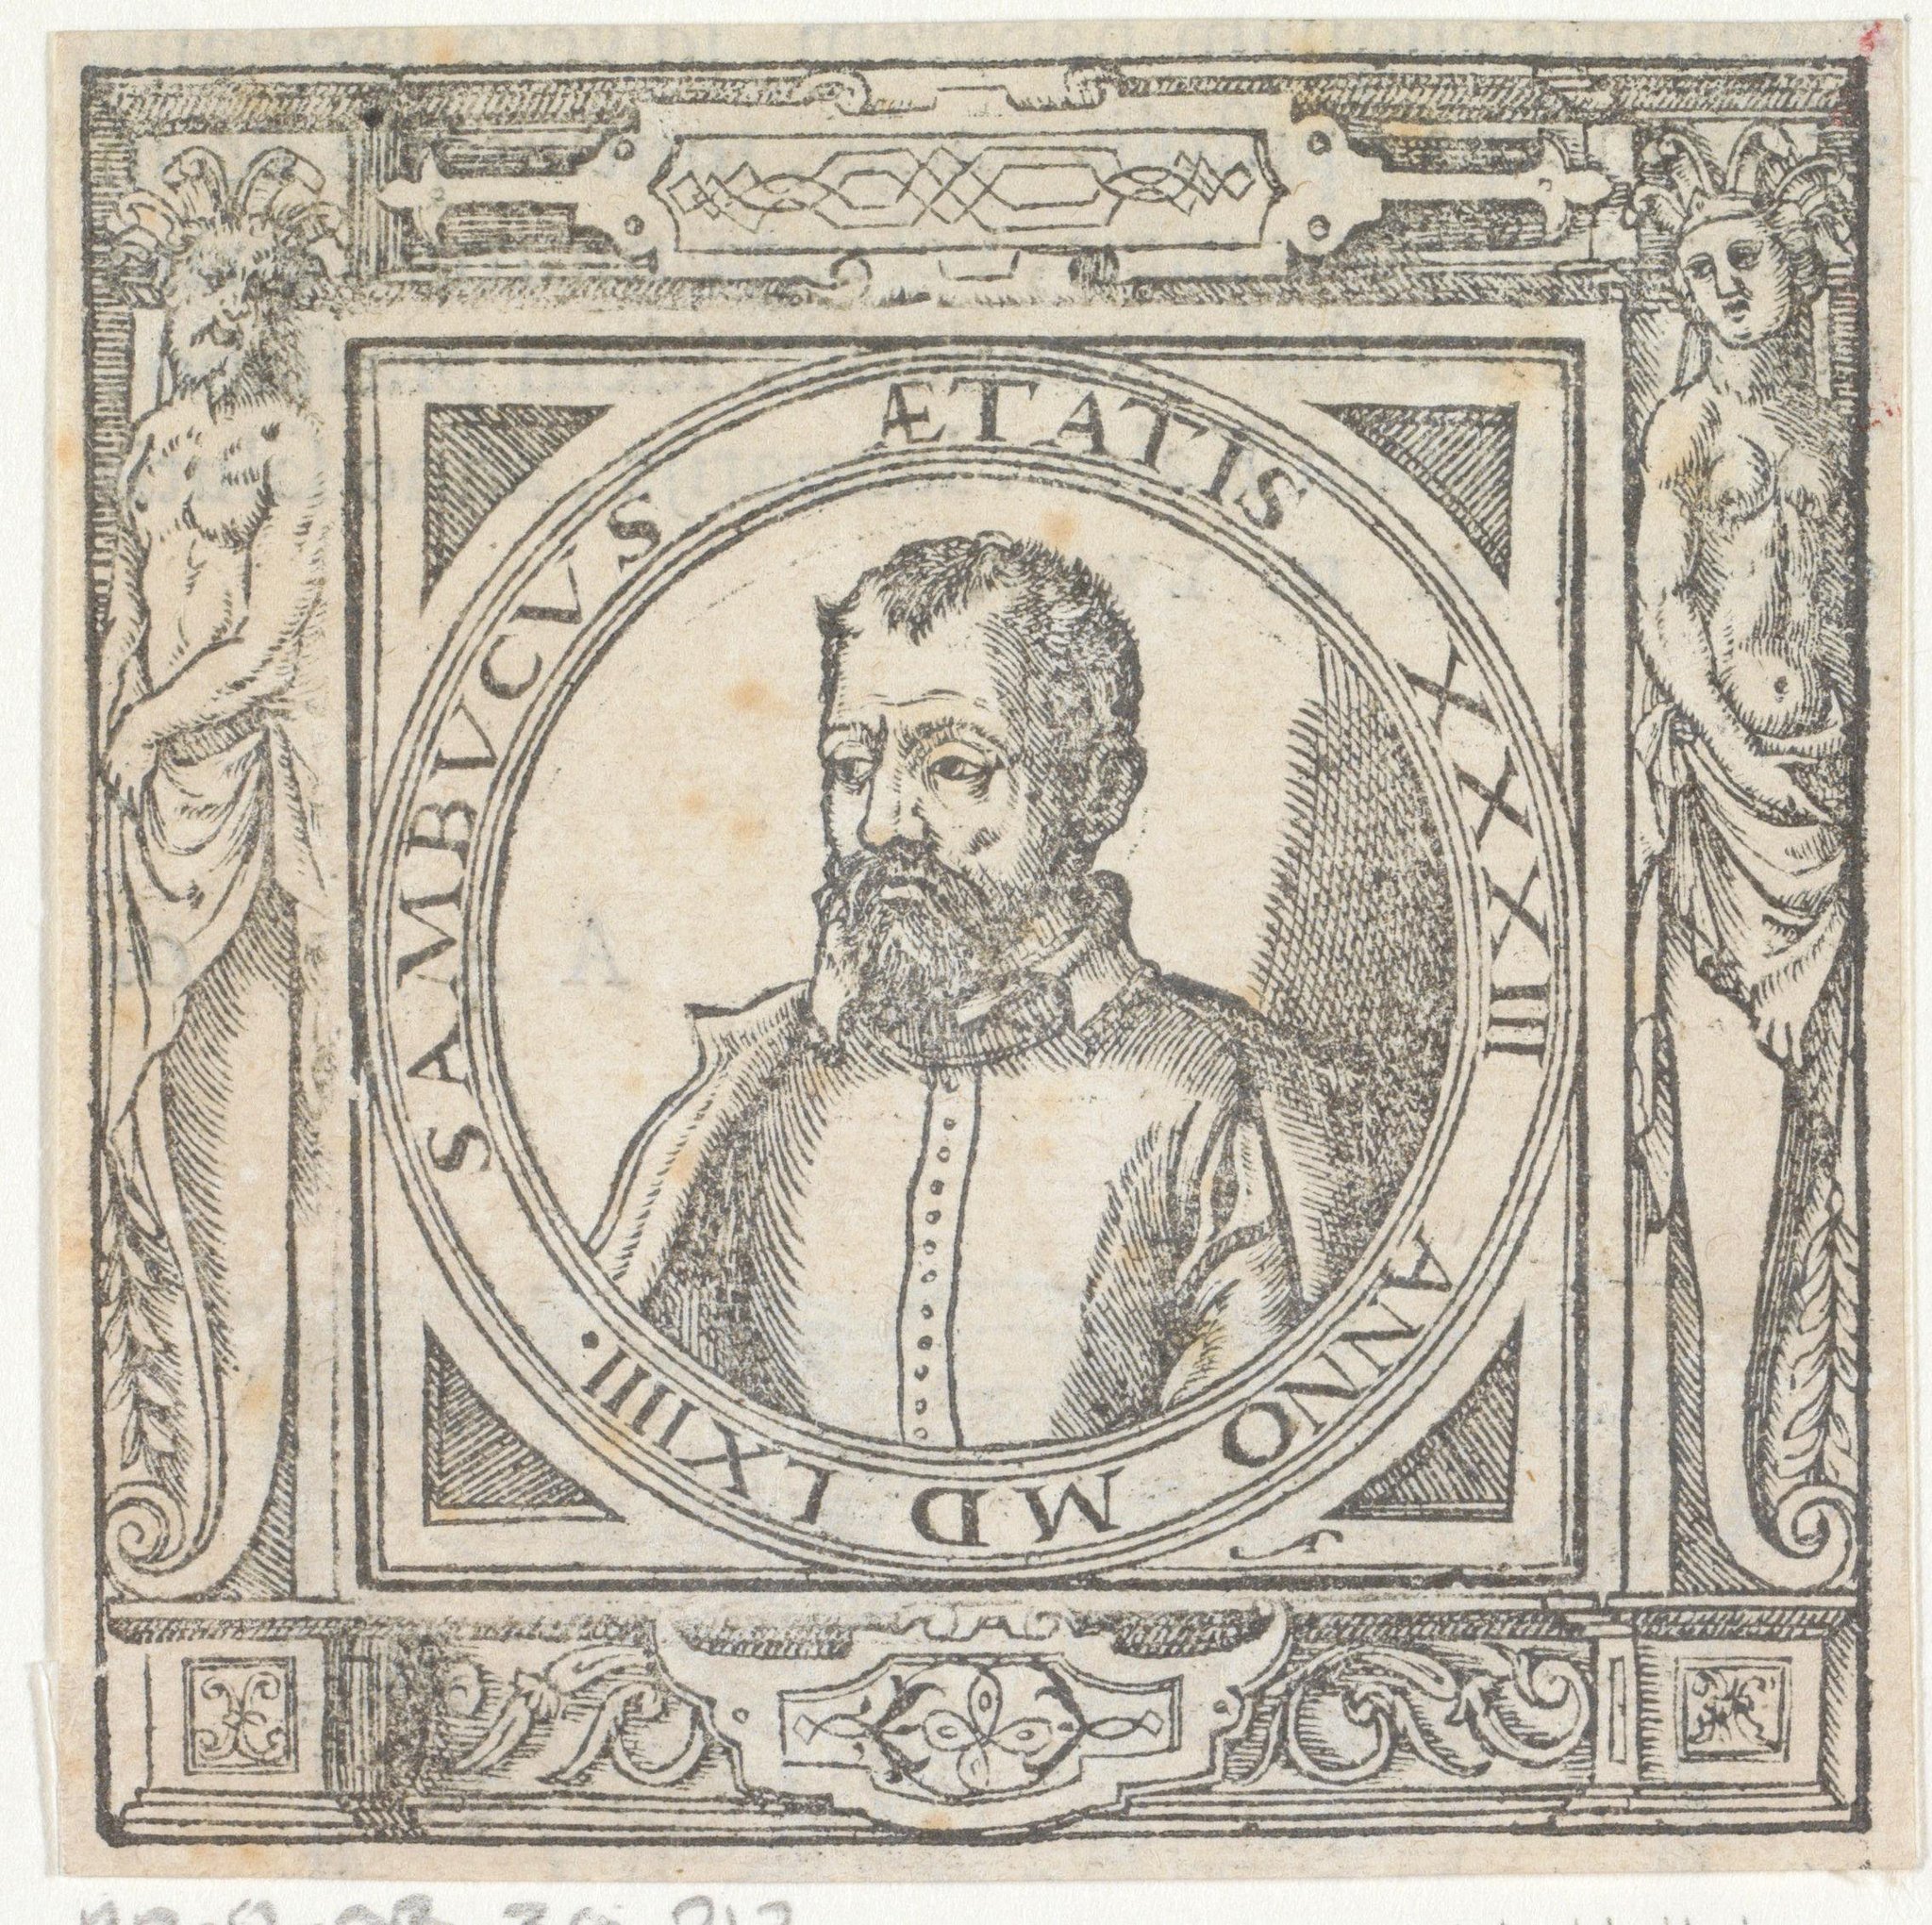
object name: print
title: Vignet voor: Johannes Sambucus. Emblemata, et aliqvot nvmmi antiqvi operis. Antwerpen: Christoffel Plantijn, 1564-1584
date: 1564-1584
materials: paper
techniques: letterpress printing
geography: antwerp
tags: vienna, johannes sambucus, vignette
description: Vignet voor: Johannes Sambucus. Emblemata, et aliqvot nvmmi antiqvi operis. Antwerpen: Christoffel Plantijn, 1564-1584.